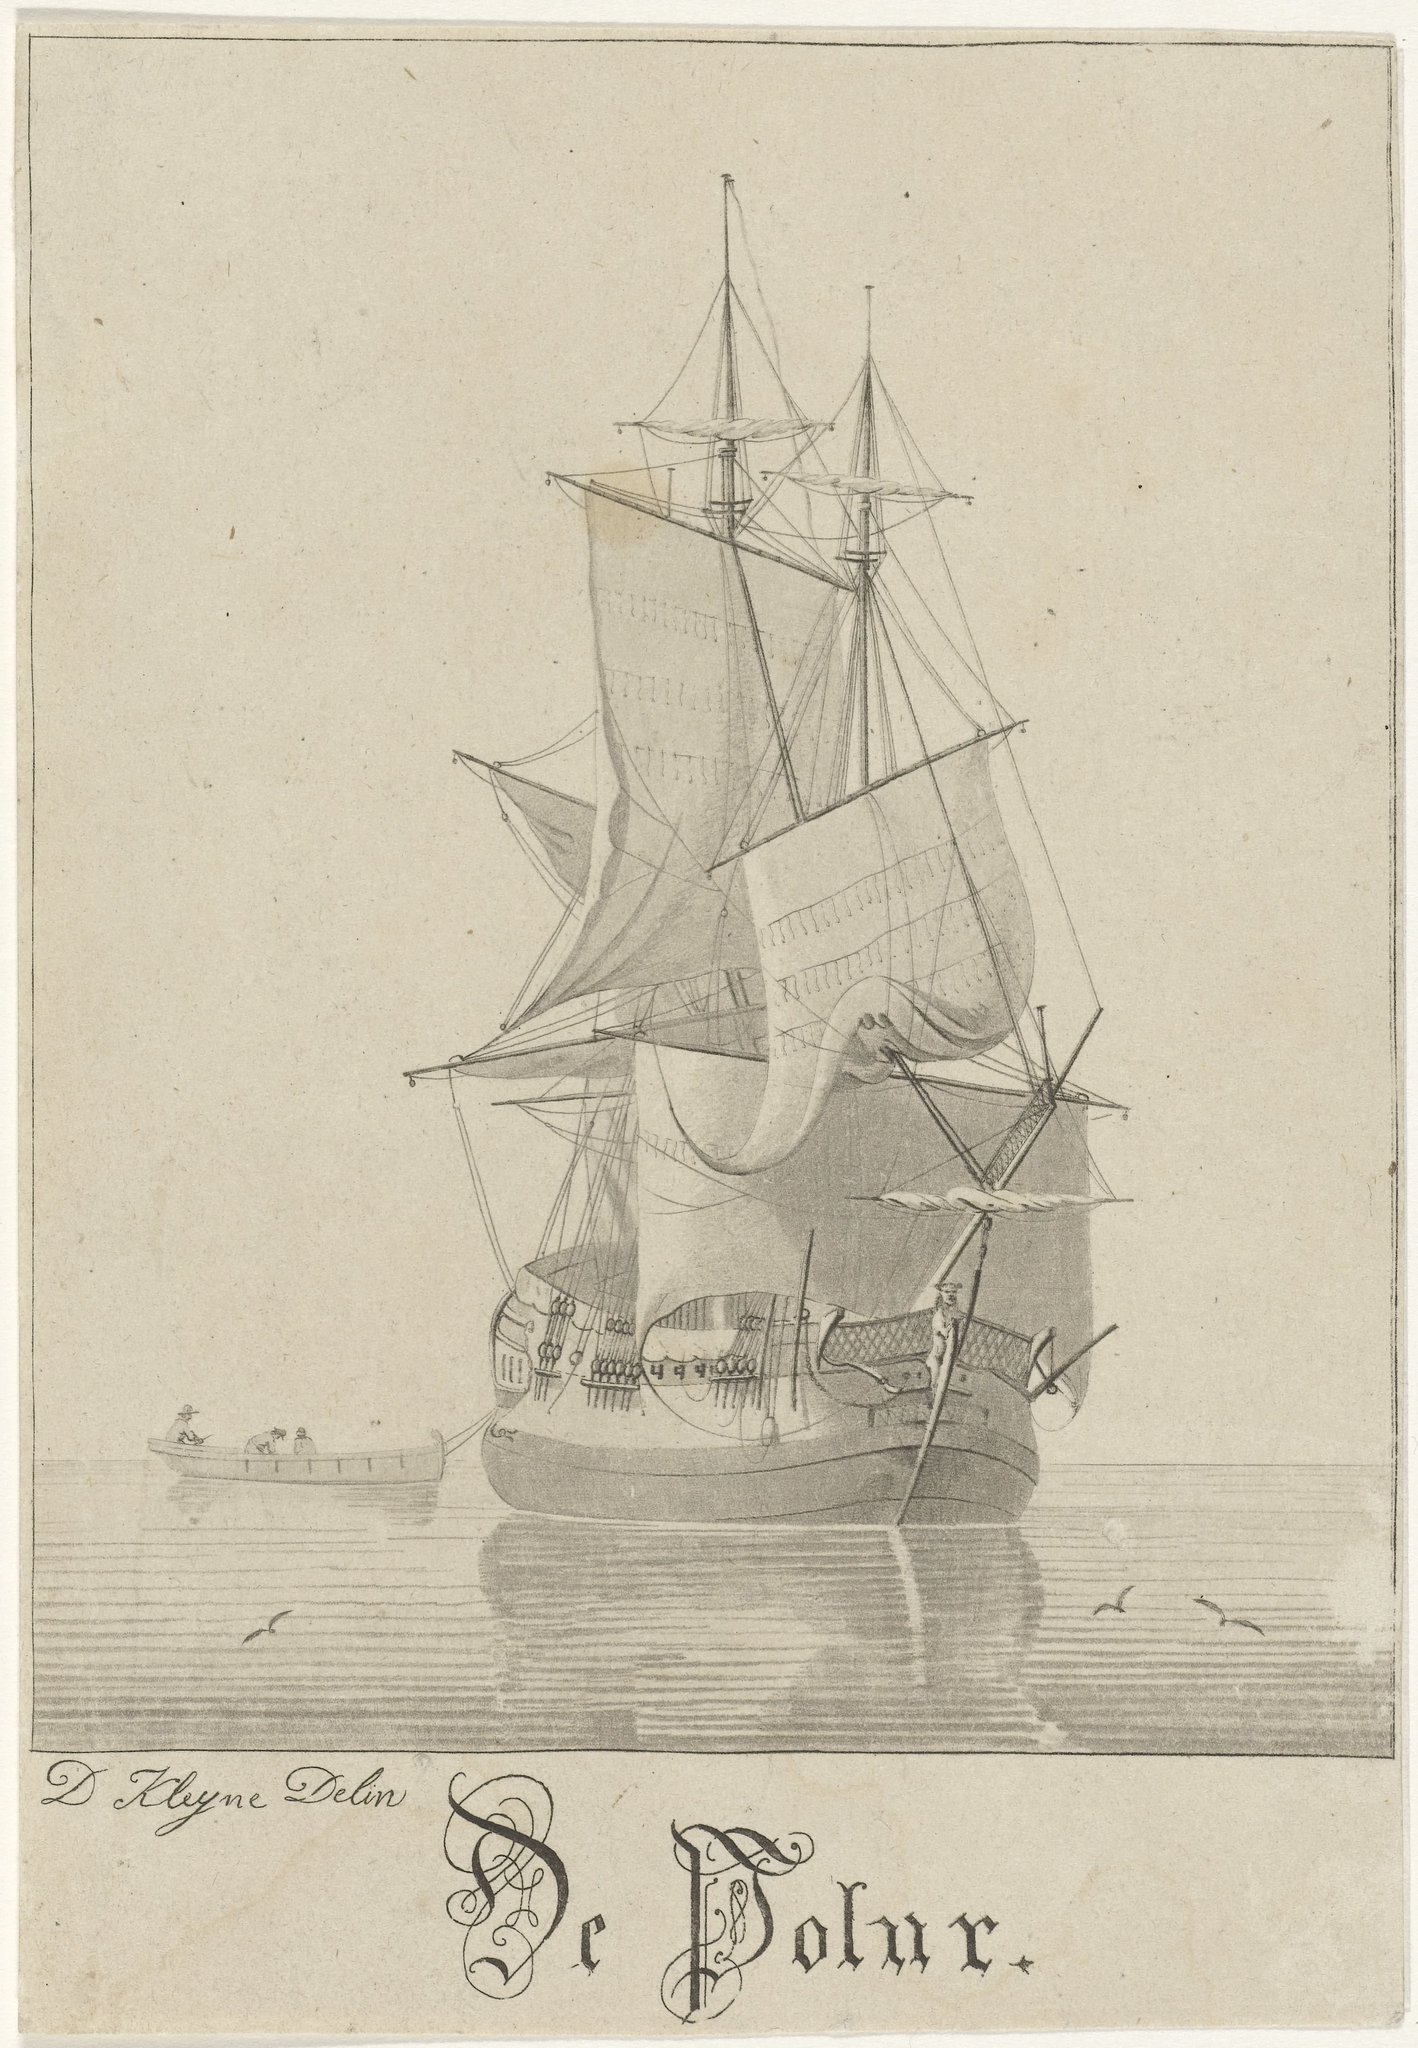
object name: print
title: Zeilschip en sloep op stil water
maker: david kleyne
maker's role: draughtsman, painter, print maker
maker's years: 1754-1805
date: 1763-1805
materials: paper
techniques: aquatint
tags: sailing-ship, sailing-boat, rowing-boat, canoe, etc., fishing (sports)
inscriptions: collector's mark: Lugt 2228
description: Een zeilschip, waarvan het boegbeeld te zien is, en een sloep op stil water. In de sloep zitten drie figuren, waarvan er een aan het vissen is. De prent maakt deel uit van een serie met zeilschepen.